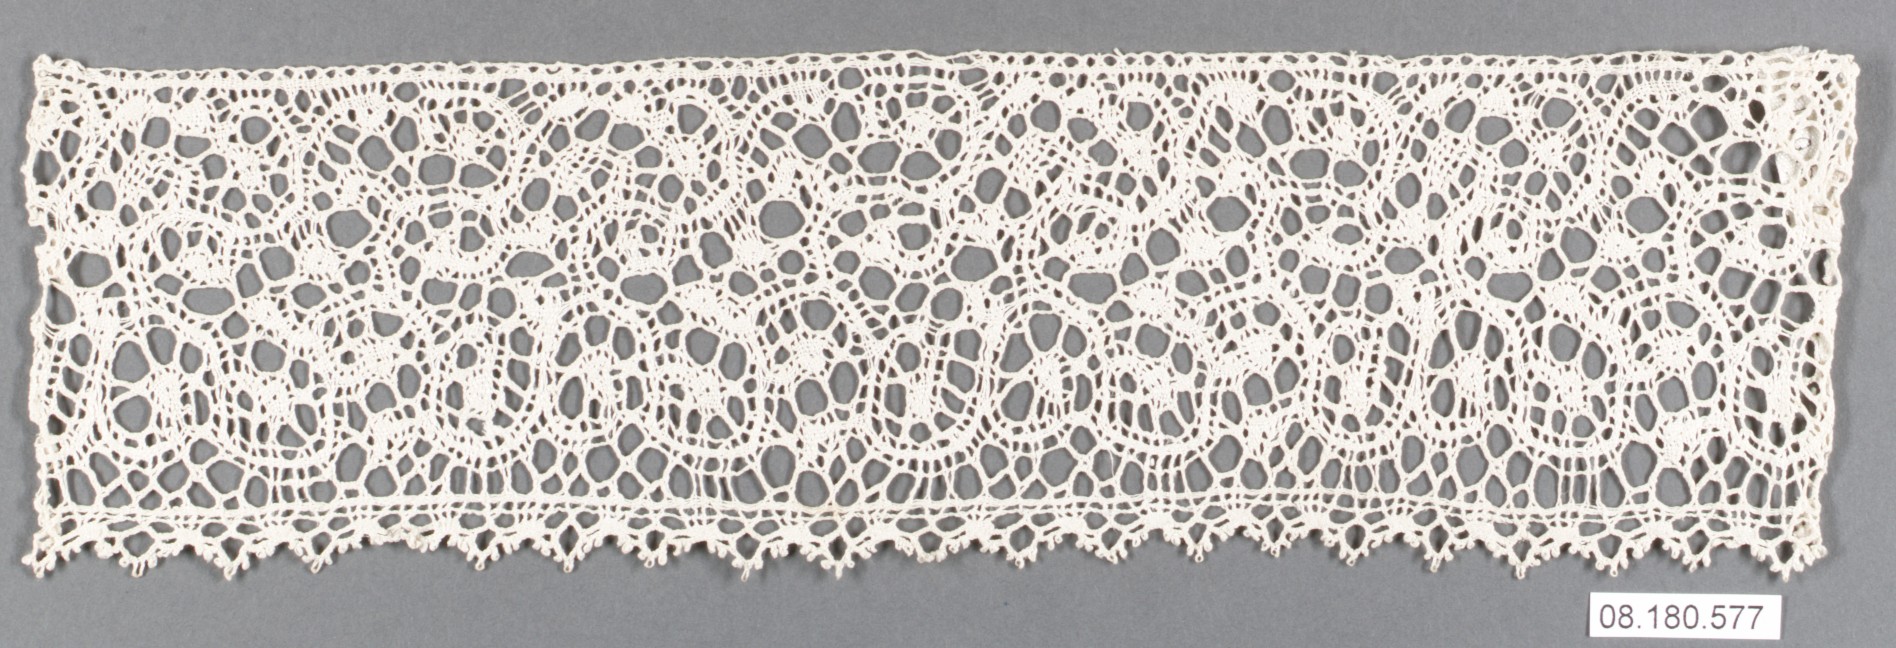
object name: piece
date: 1801-1900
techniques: lace